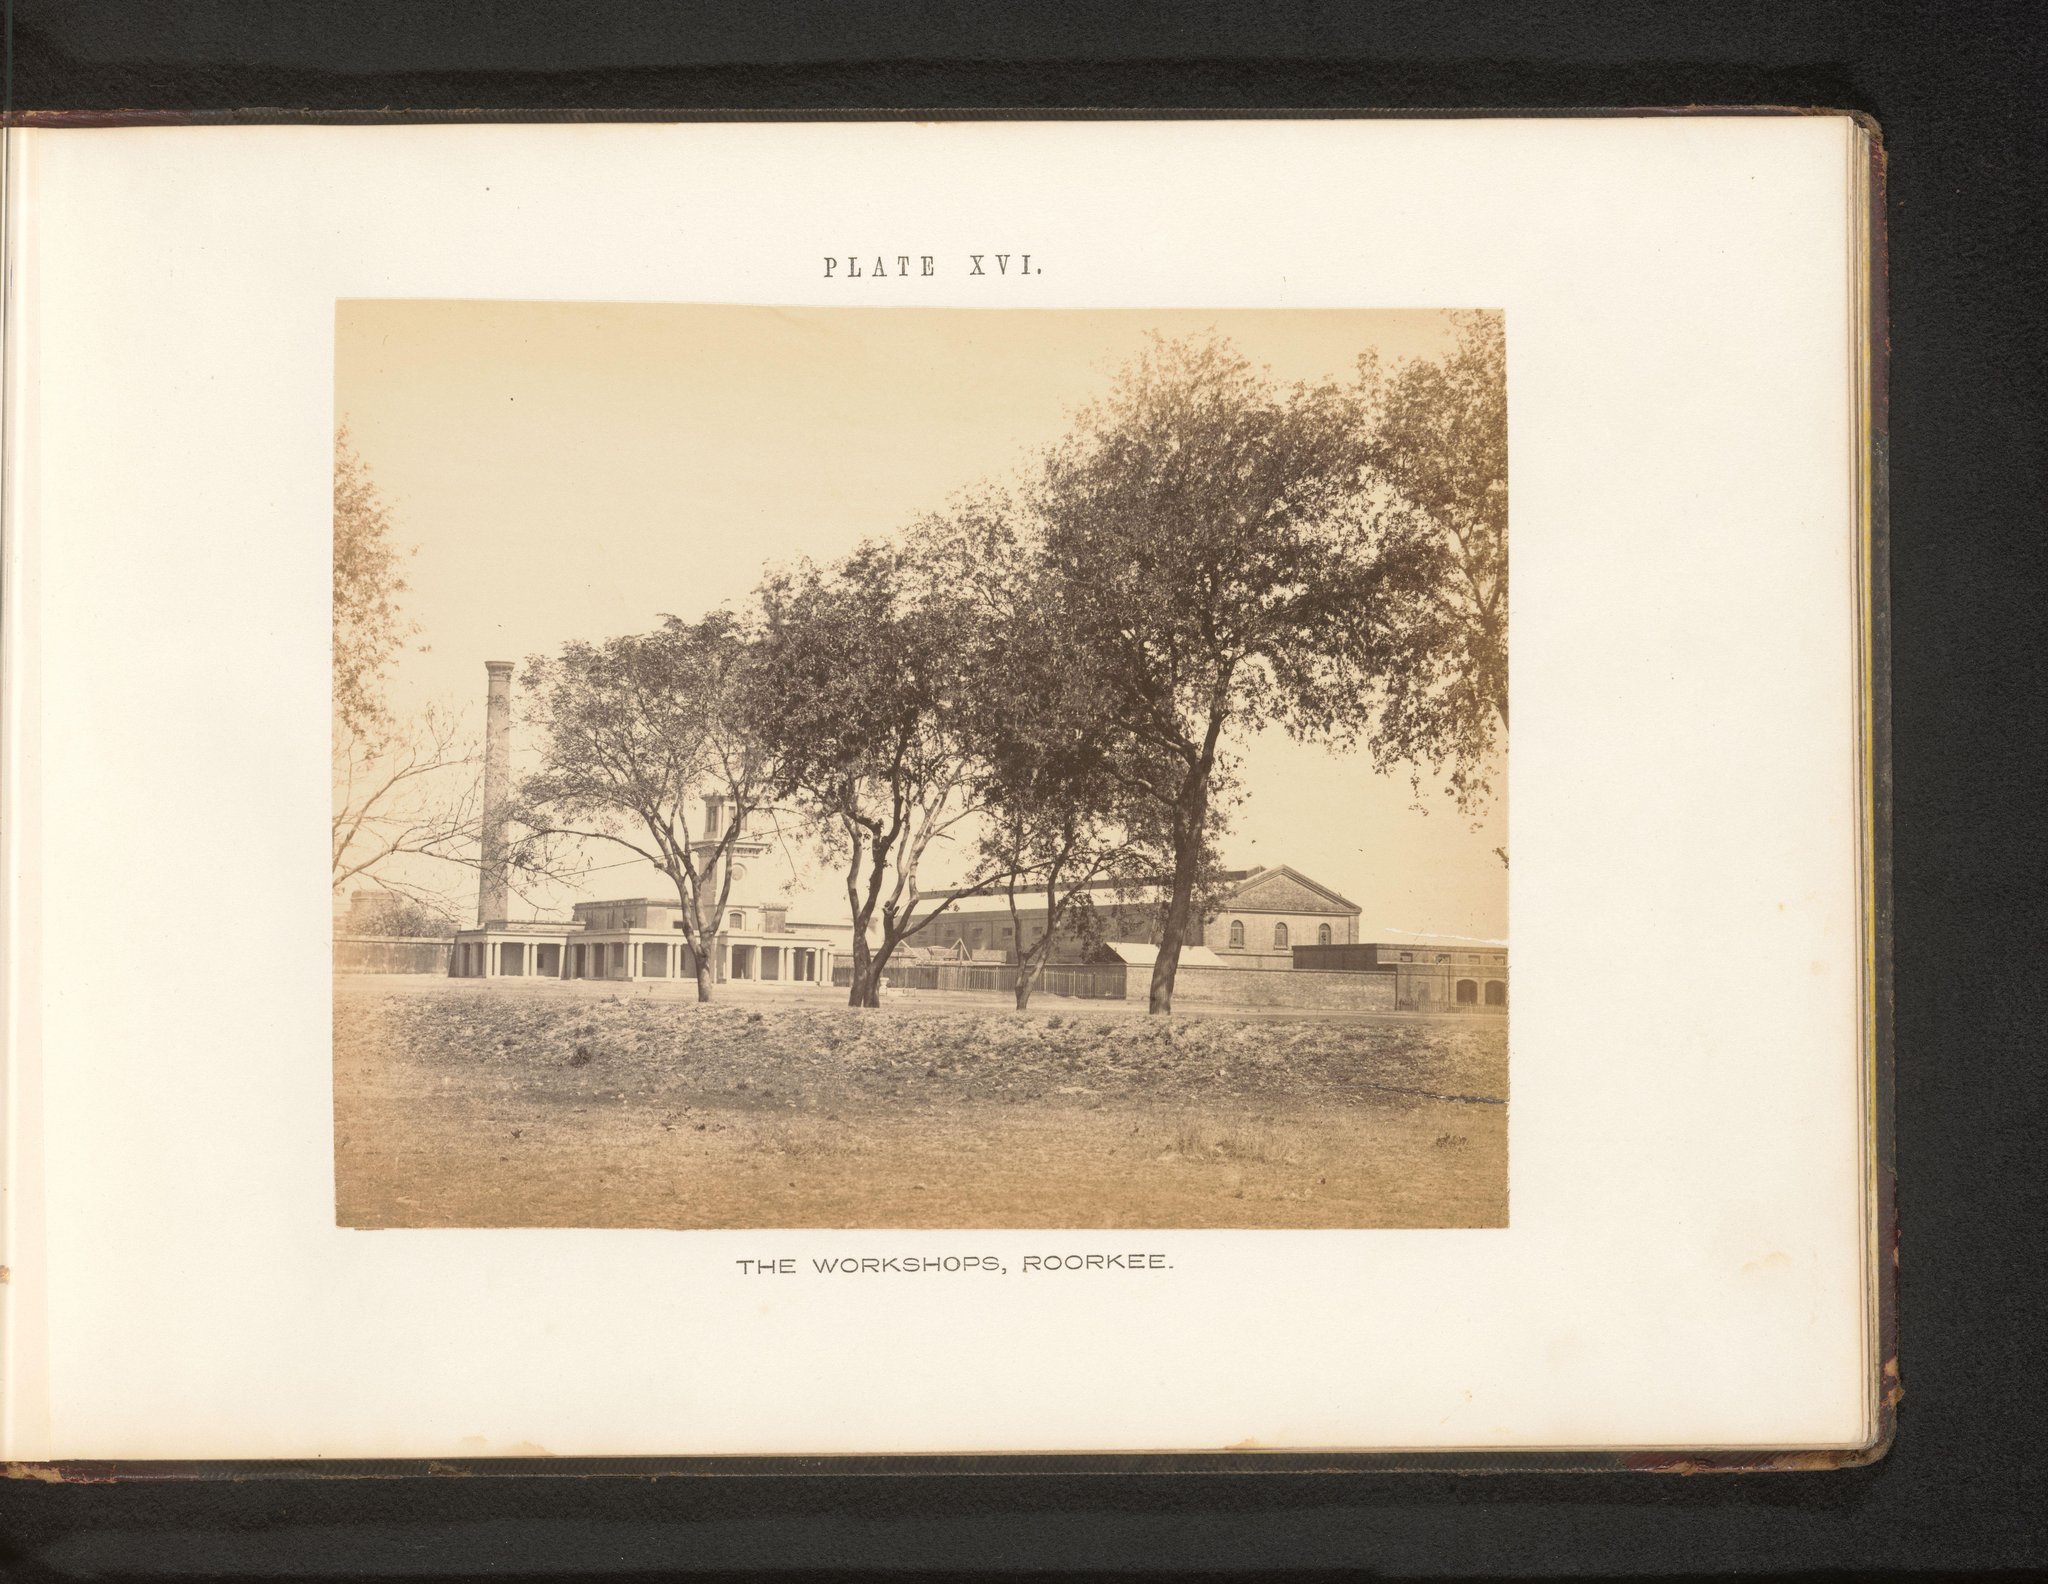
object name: photograph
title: The workshops, Roorkee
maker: thomas george glover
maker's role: fotograaf, luitenant-kolonel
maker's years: 1825-1881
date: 1862-1867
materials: photographic support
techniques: albumen print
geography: roorkee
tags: chimney, trees, civic architecture; edifices; dwellings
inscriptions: inscription: ‘Plate XVI’